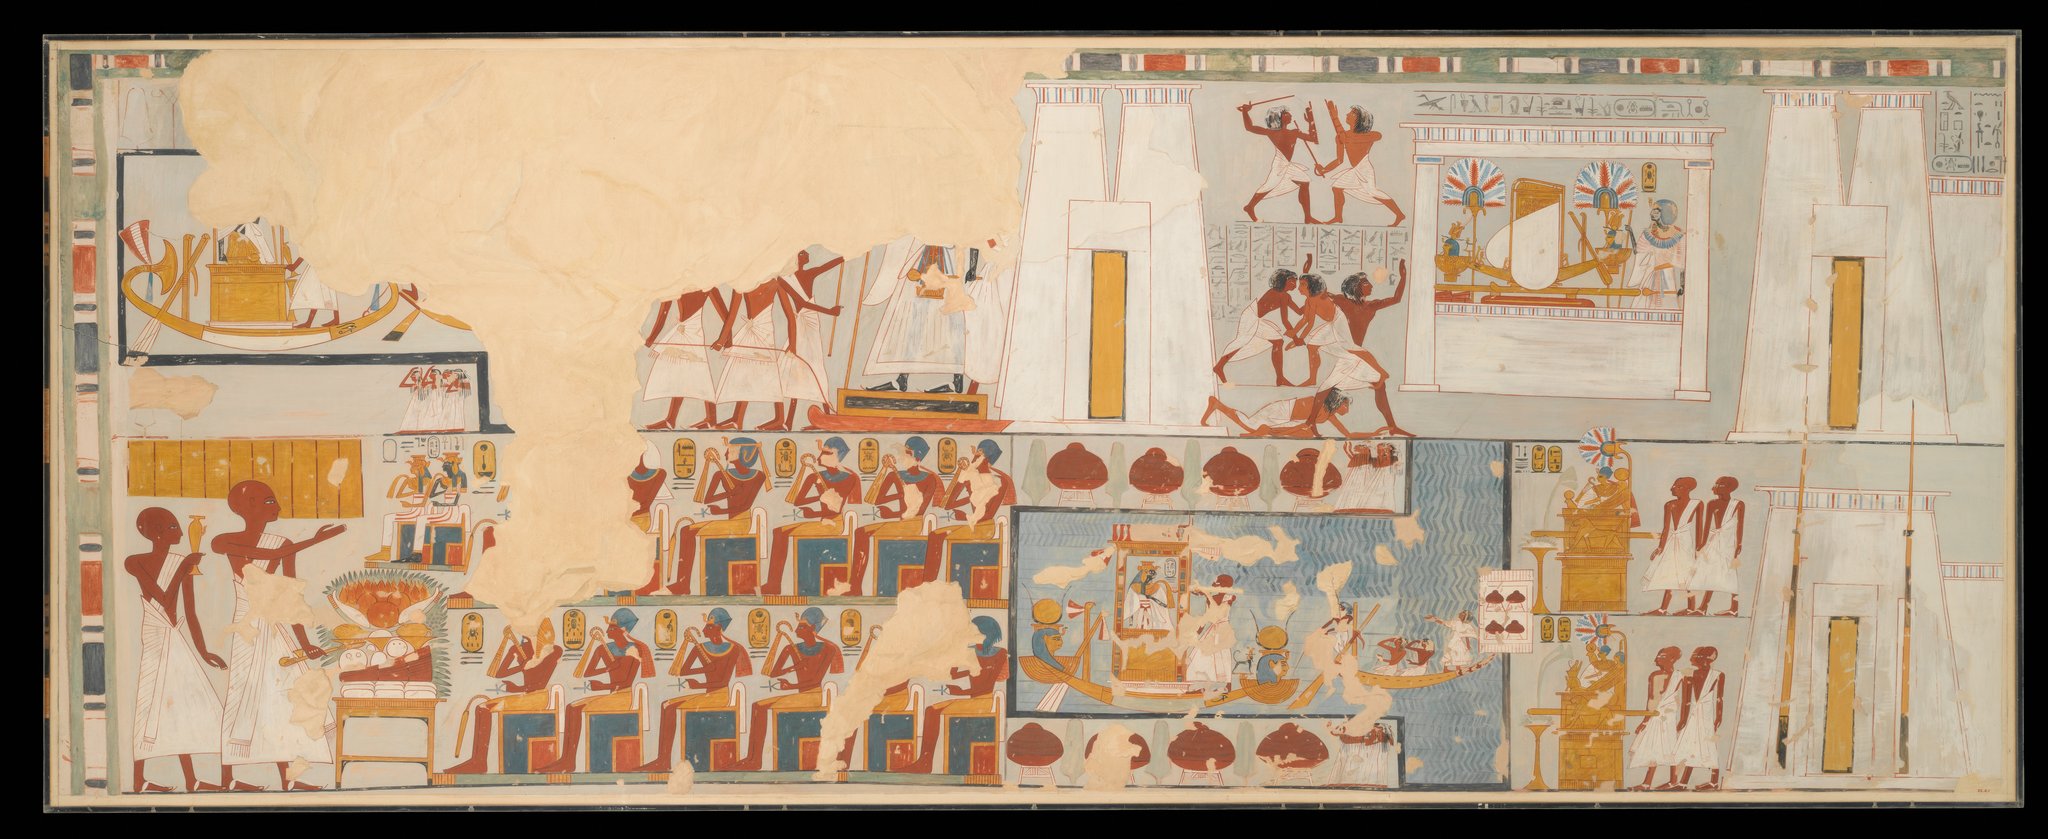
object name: facsimile, amenmose tt 19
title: Festival Scene, Tomb of Amenmose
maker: charles k. wilkinson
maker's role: artist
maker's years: 1897-1986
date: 1295-1213 BCE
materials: paper, paint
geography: egypt